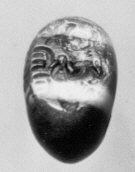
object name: stamp seal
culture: sasanian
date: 201-700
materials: stone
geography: iran or mesopotamia